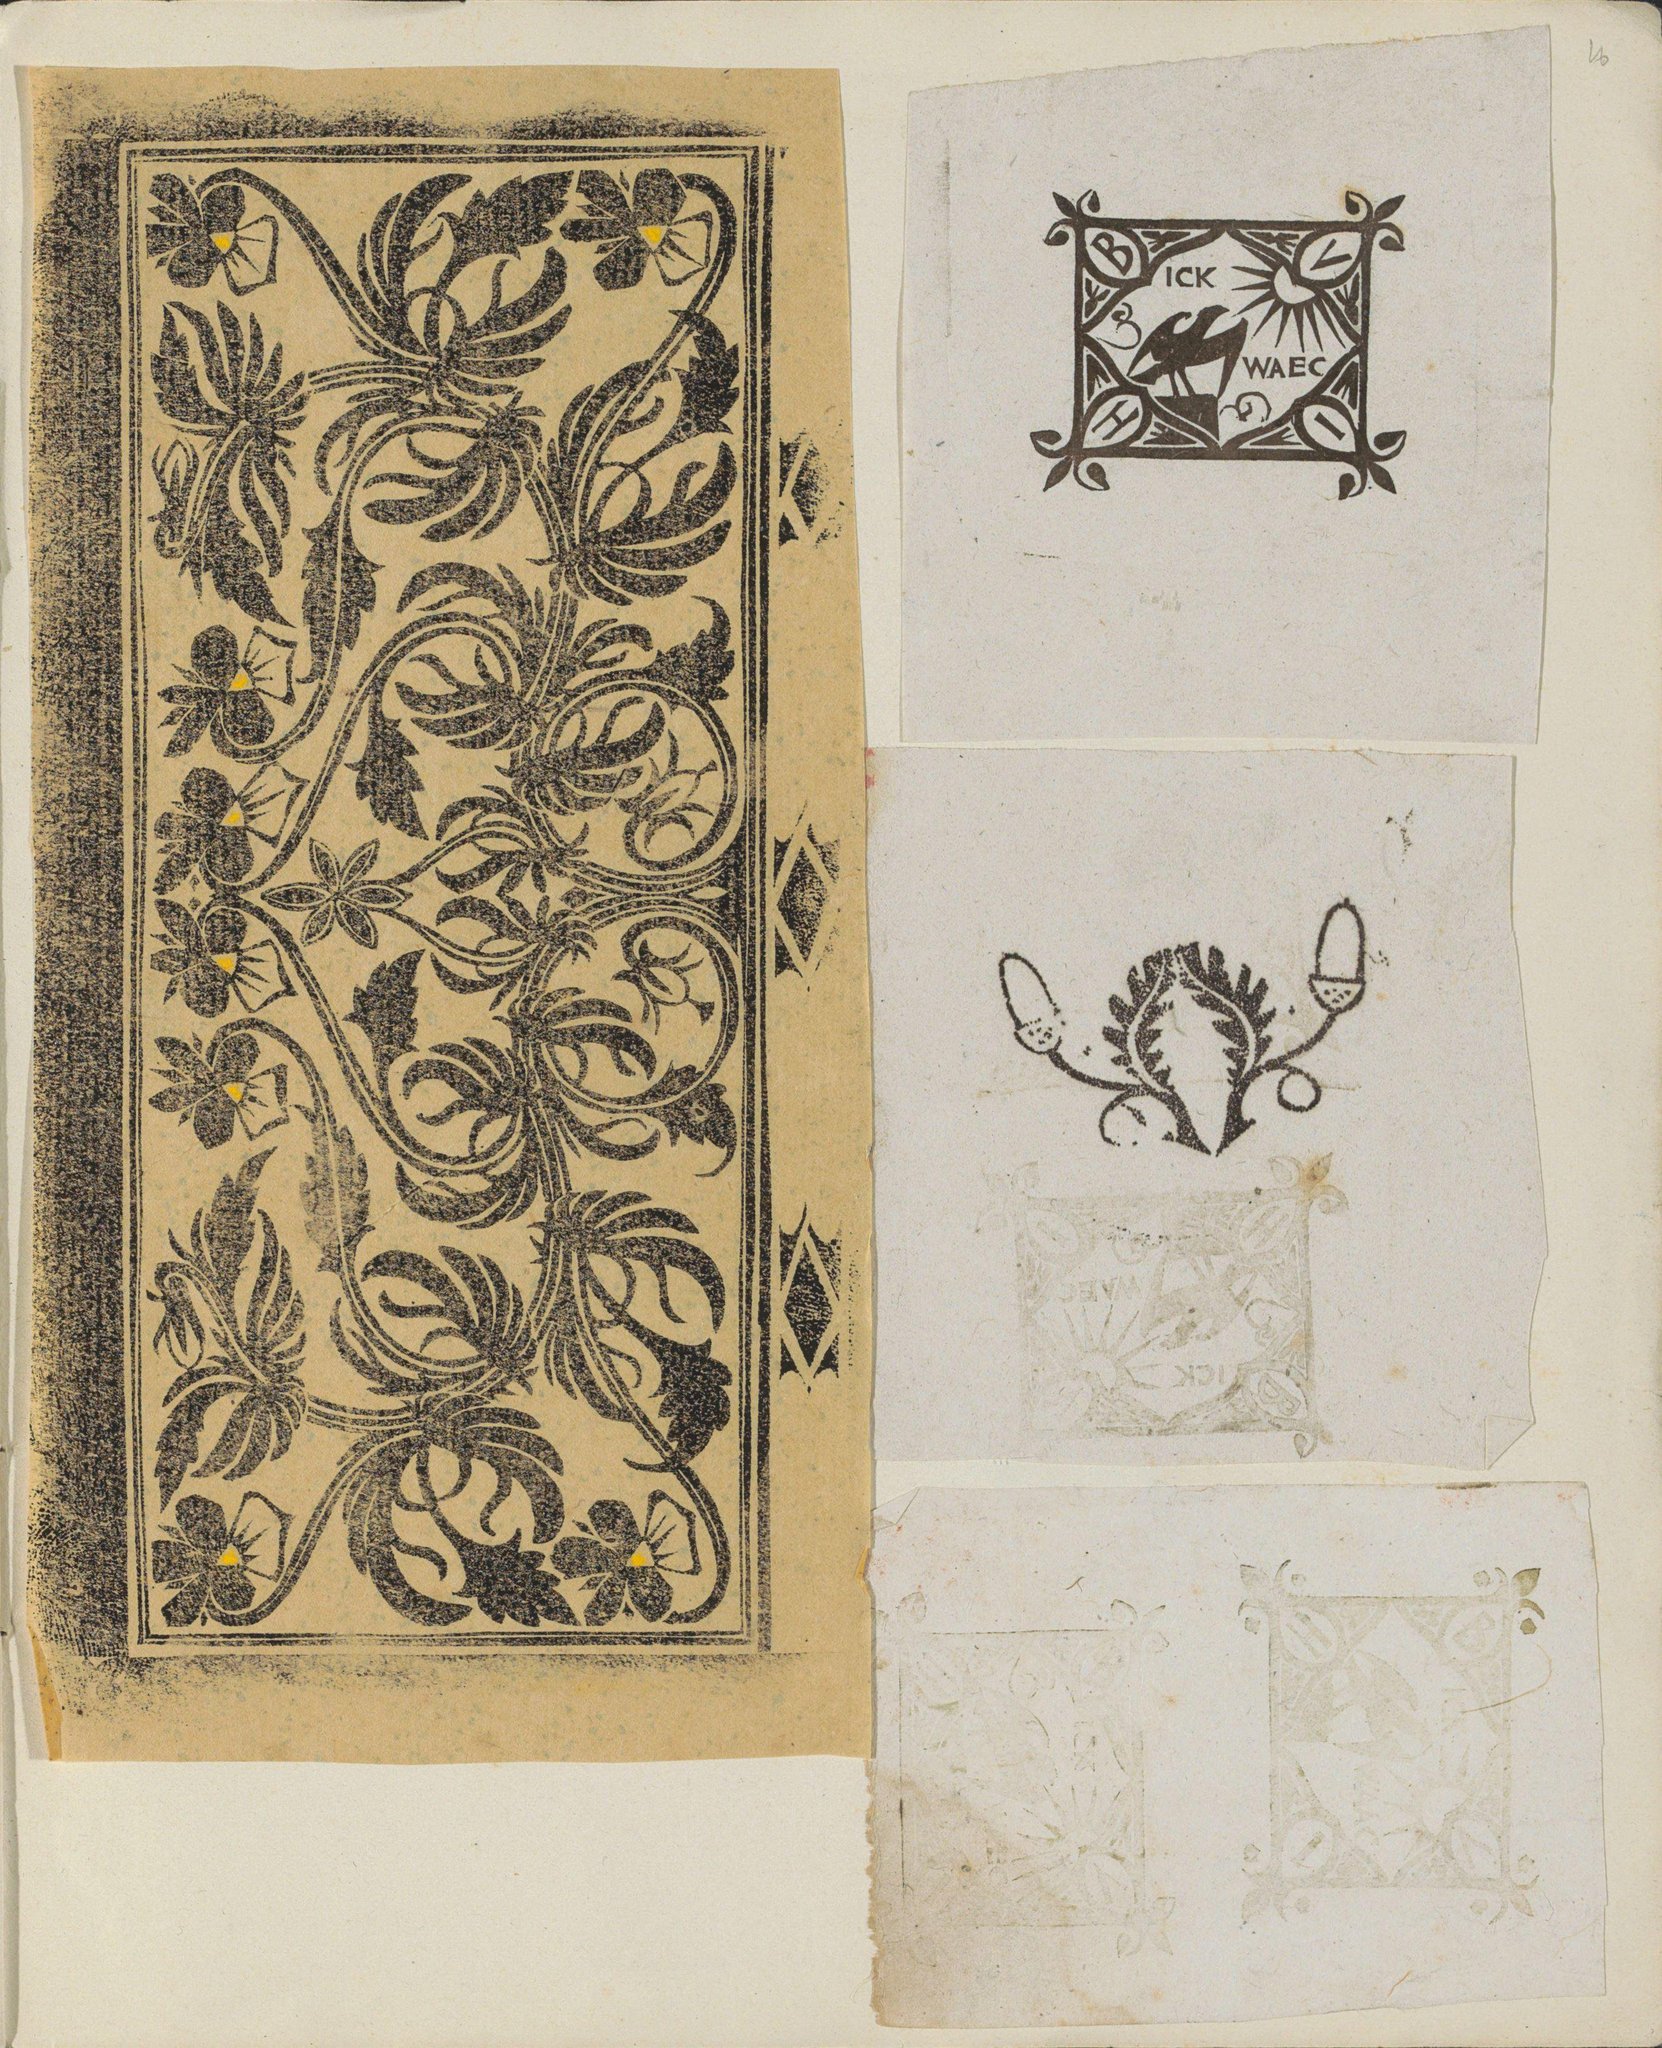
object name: album leaf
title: Boekversieringen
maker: gerrit willem dijsselhof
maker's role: designer, draughtsman, print maker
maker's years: 1866-1924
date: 1874-1924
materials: paint, paper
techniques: brush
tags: decoration of printed matter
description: Versieringen met bloemen, bladen en eikels. Blad 16 recto uit een album met 17 bladen.